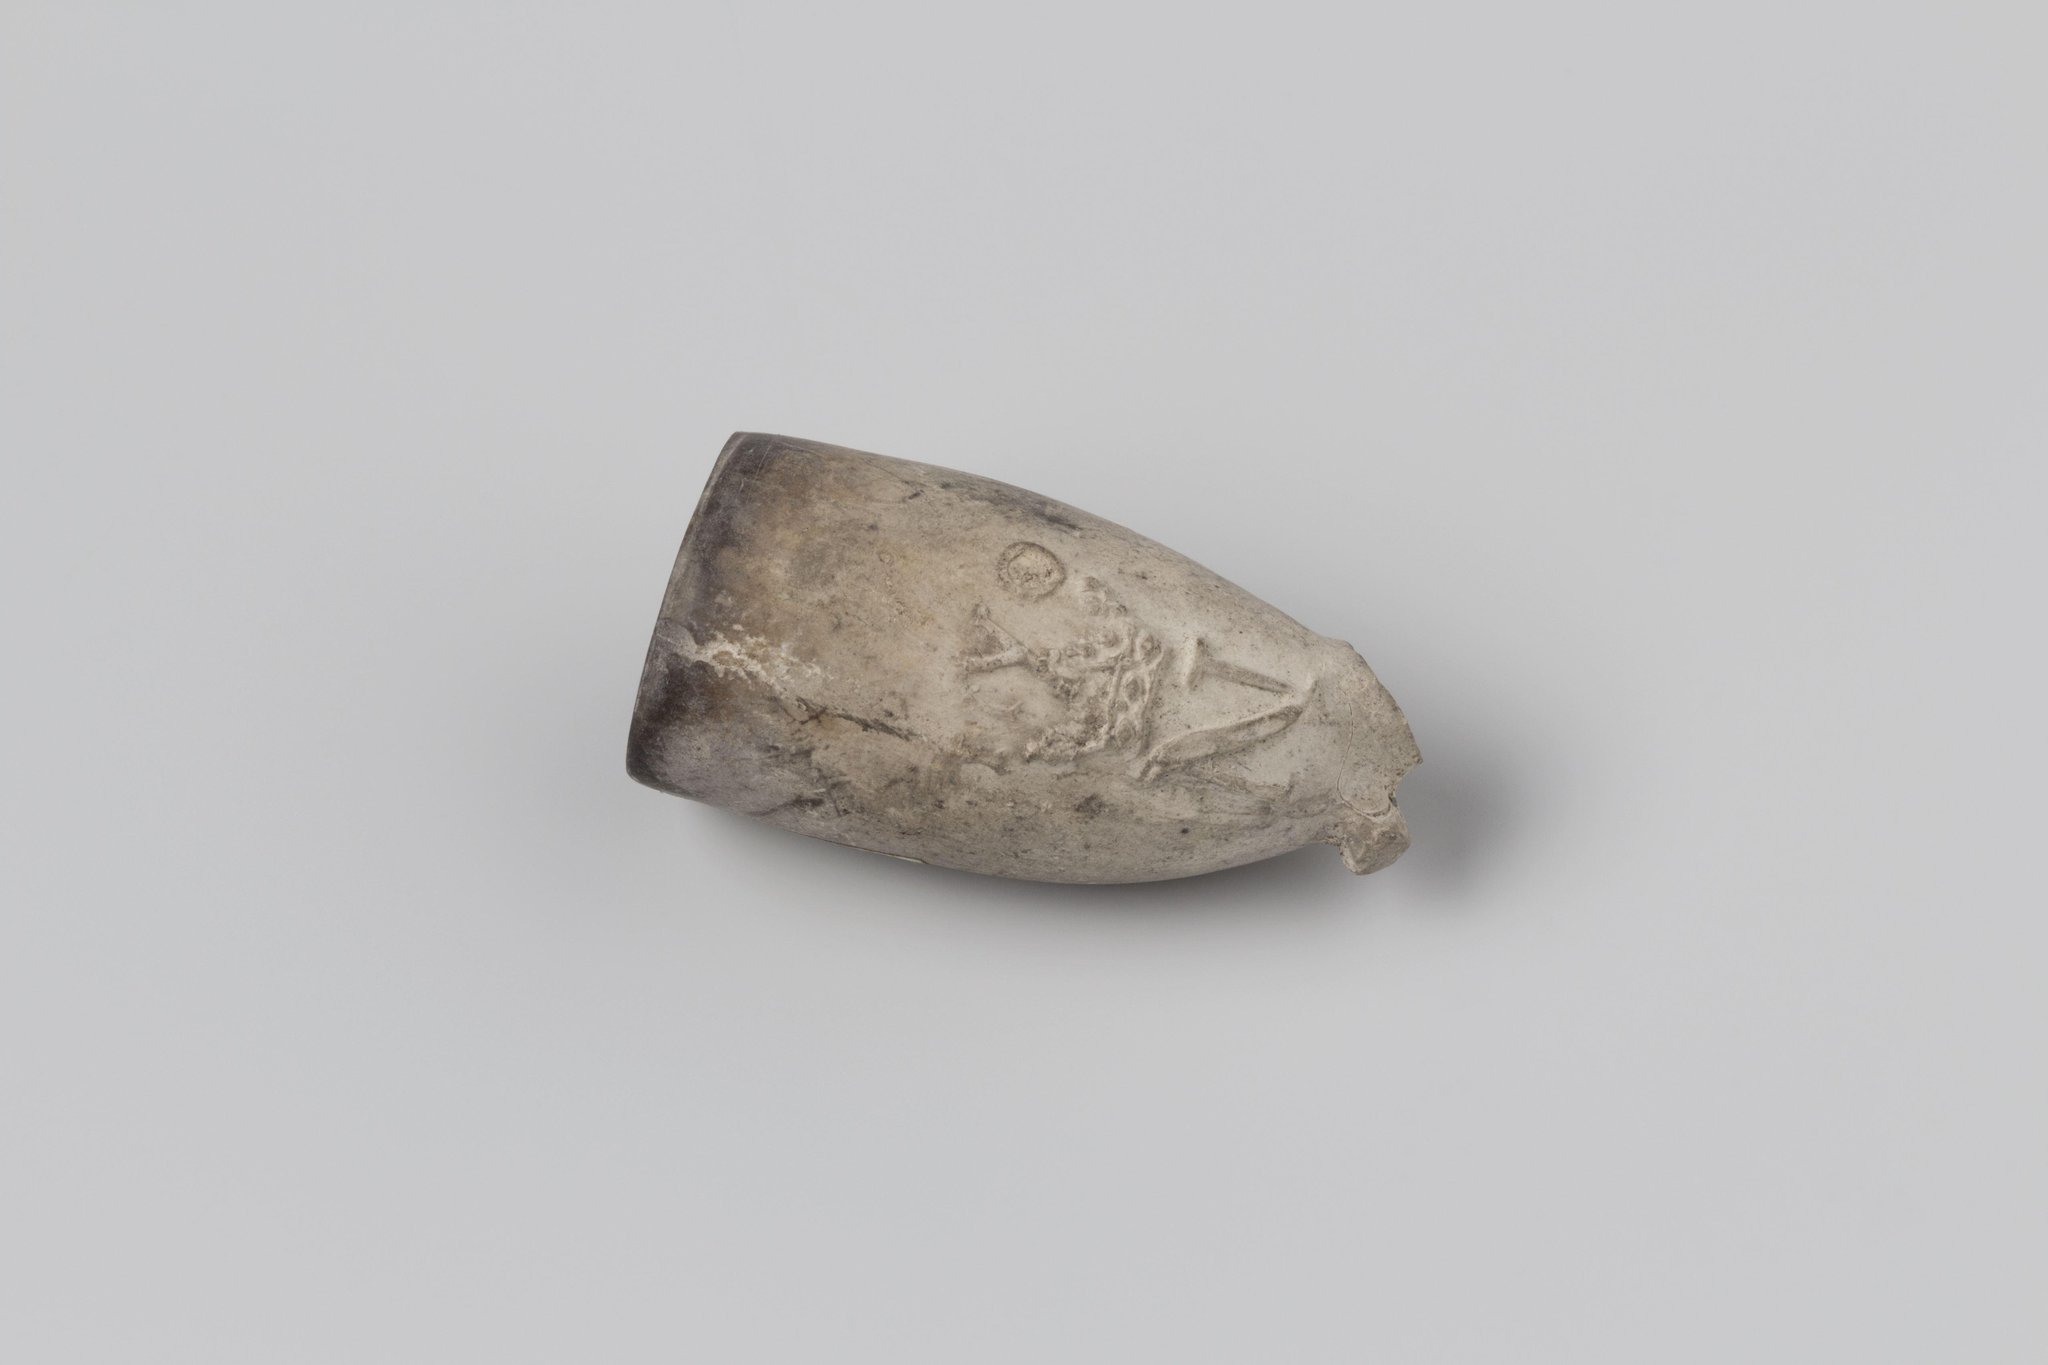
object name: fragment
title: Pijpenkop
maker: machiel andriesz van oosterhout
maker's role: pijpenfabrikant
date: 1760-1775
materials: clay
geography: schoonhoven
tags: directeur, hoogleraar, caspar jacob christiaan reuvens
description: Pijpenkop met de letters M V O en gekroonde N. Van de opgravingen op de Hofstede Arentsburg 1827-1831 onder toezicht van Professor Reuvens.